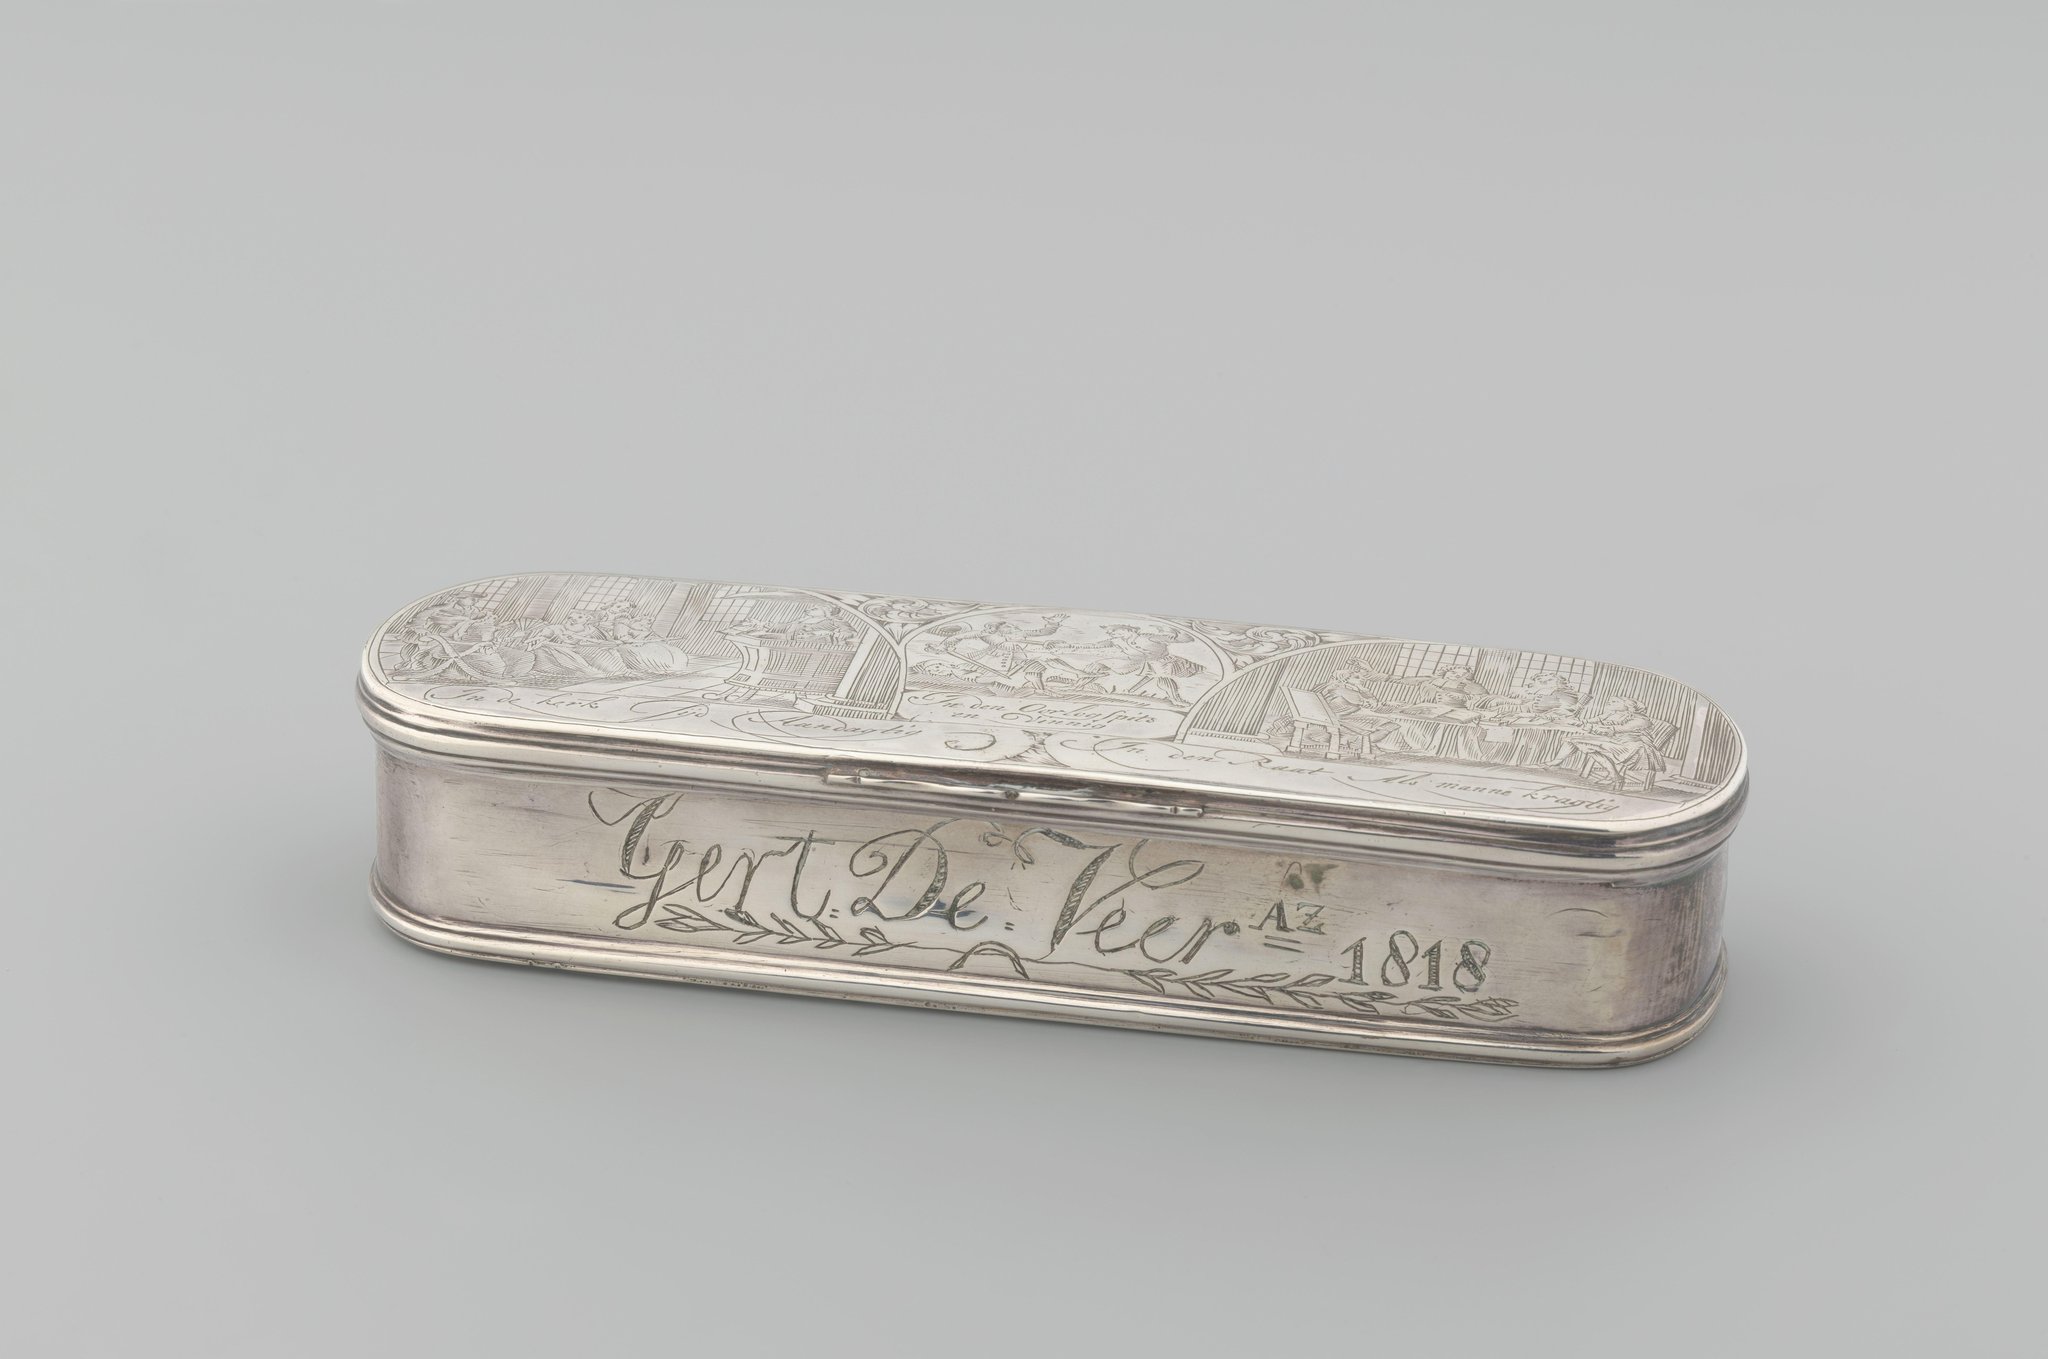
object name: tobacco box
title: Tabaksdoos met aanbevelingen voor de man van de wereld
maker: simon woortman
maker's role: silversmith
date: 1793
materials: silver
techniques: engraving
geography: amsterdam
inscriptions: maker's mark: ‘SW’, inscription: ‘Gerrit de Veer 1818’, inscription: ‘stadskeur Amsterdam, jaarletter I = 1793’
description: De rechthoekige doos heeft afgeronde uiteinden en een scharnierend deksel. Op het deksel zijn drie scènes gegraveerd; achtereenvolgens wordt een kijkje in de kerk, een kijkje op het slagveld en een kijkje in de raadkamer gegeven. Onder iedere voorstelling staat een inscriptie: in de kerk aandachtig, in den oorlog spits en vinnig en in den raad als mannen krachtig.